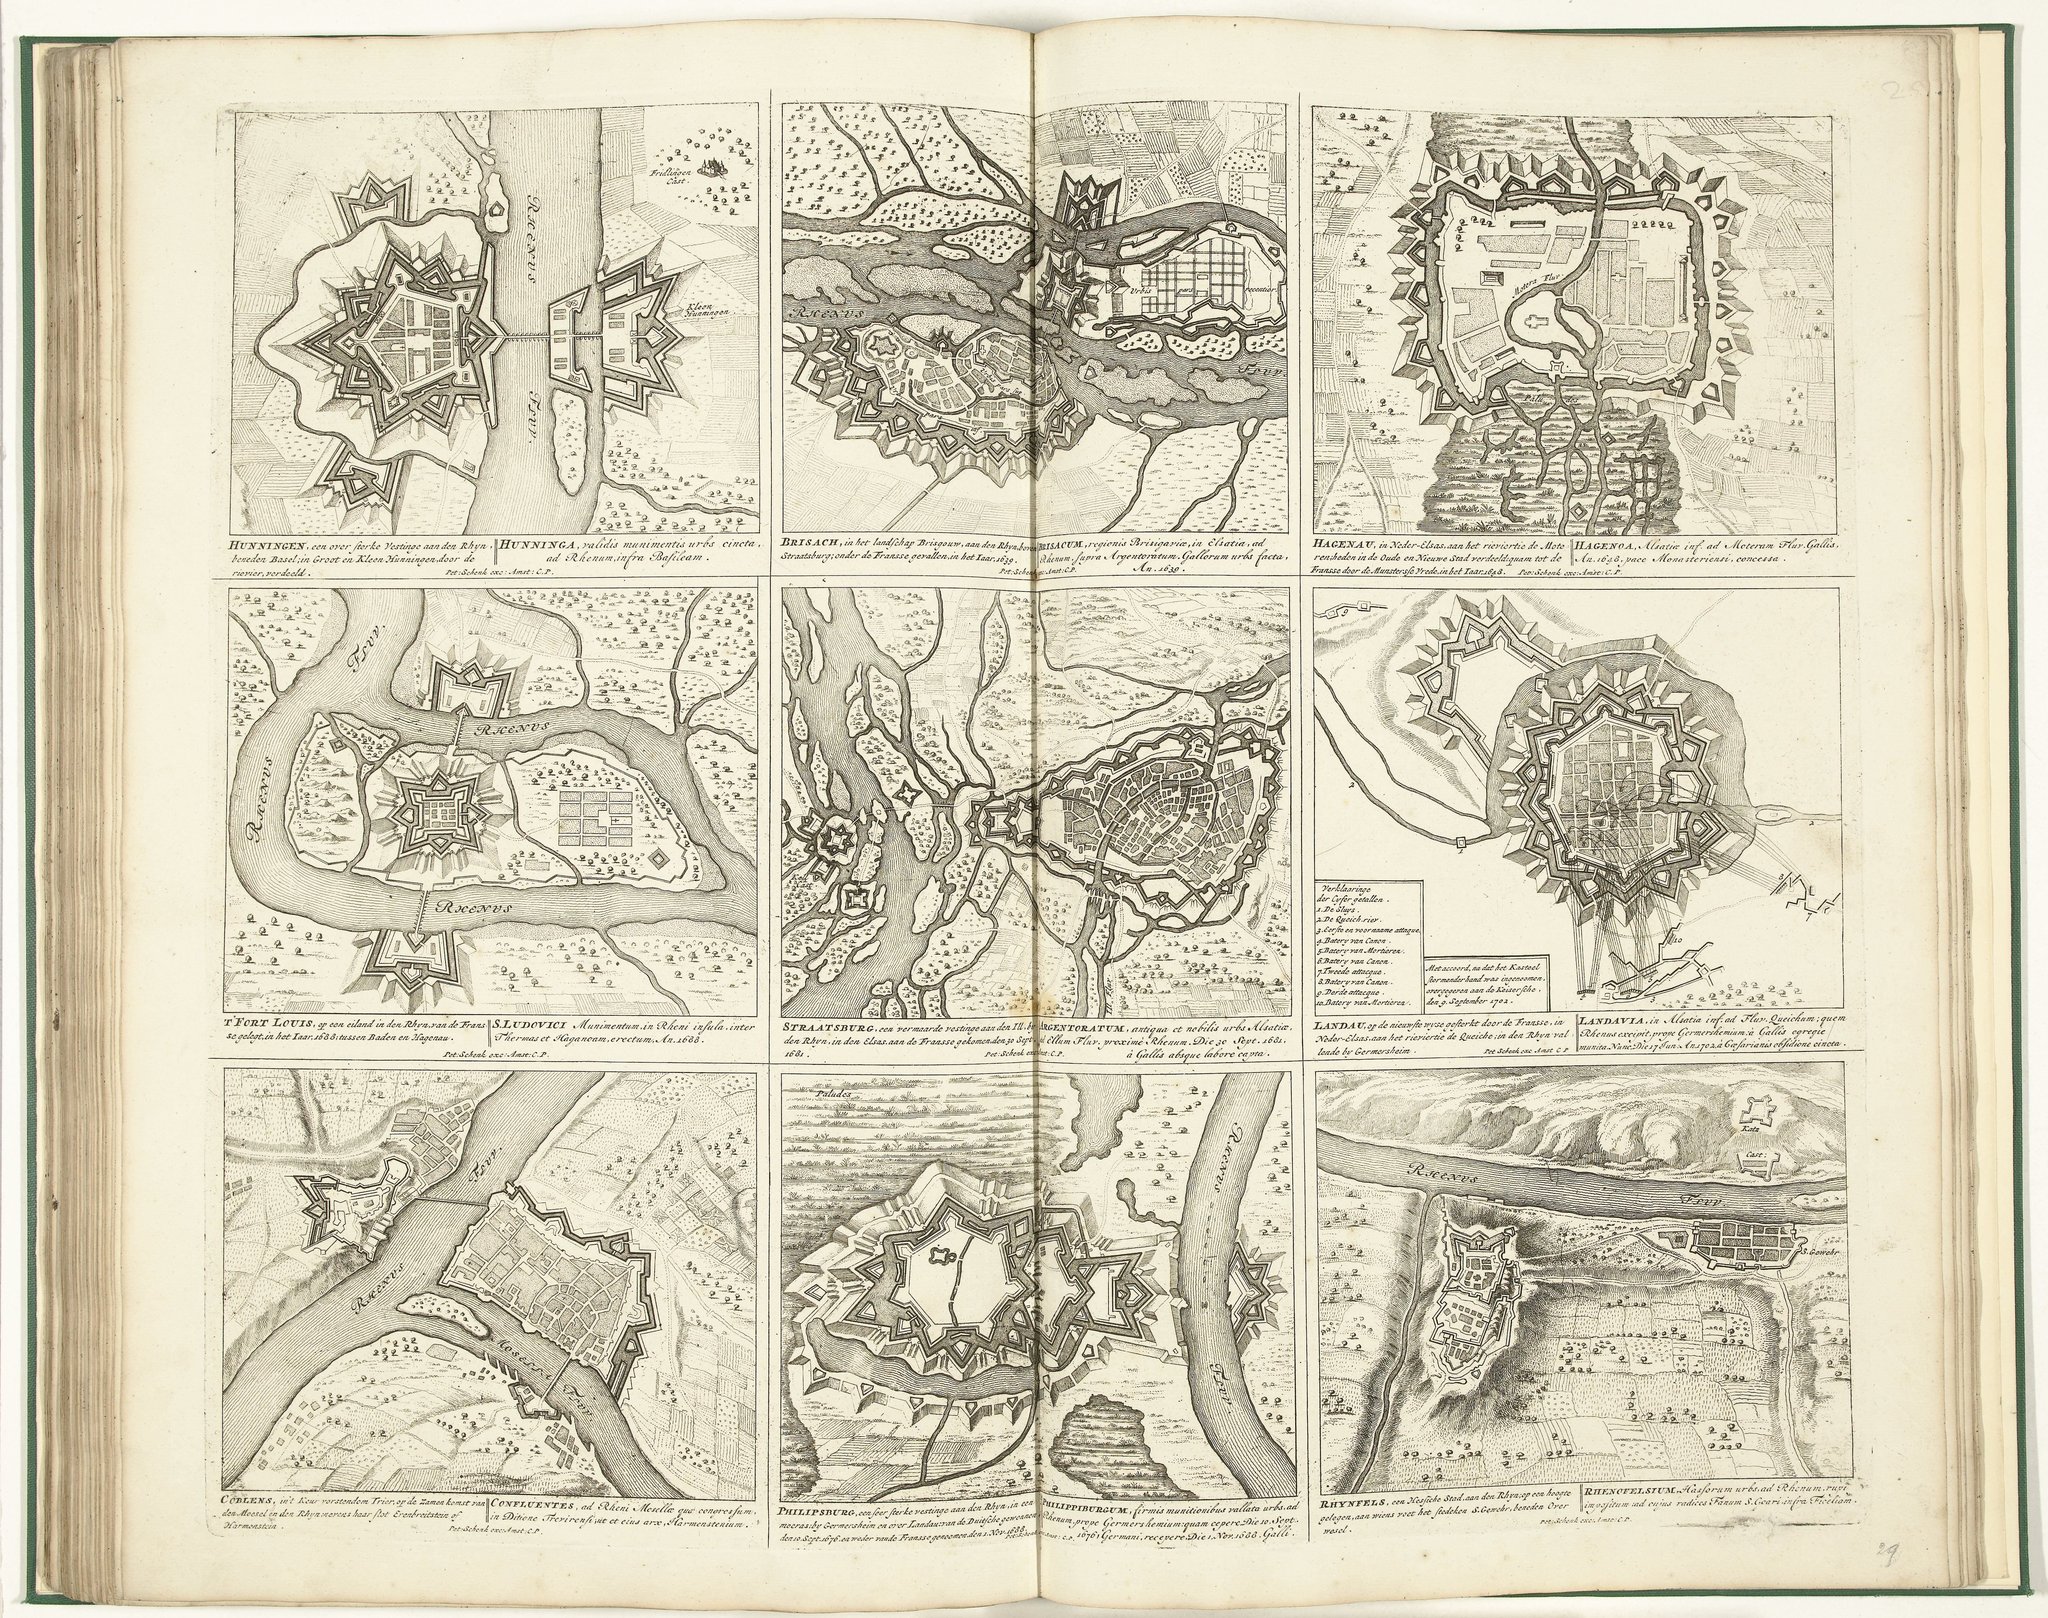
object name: print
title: Schouwburg van den oorlog (blad XXIX), ca. 1700-1710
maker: pieter schenk (i)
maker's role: print maker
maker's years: 1660-1711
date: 1700-1710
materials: paper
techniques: etching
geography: amsterdam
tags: fortress, maps of cities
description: Blad met negen plattegronden van versterkte steden. Blad XXIX in: Schouwburg van den oorlog (editie van 1720), het prentwerk met de gebundelde reeks van 31 platen over de Spaanse Successieoorlog.